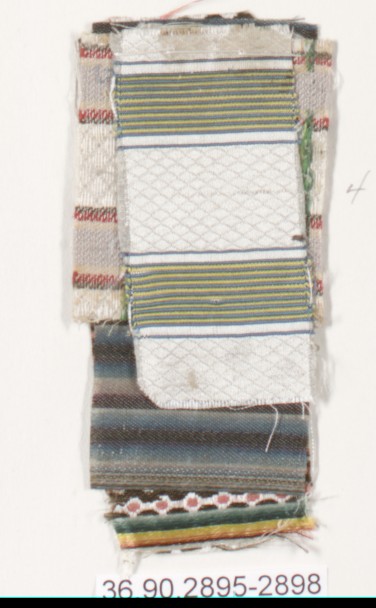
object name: piece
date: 1801-1900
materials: silk